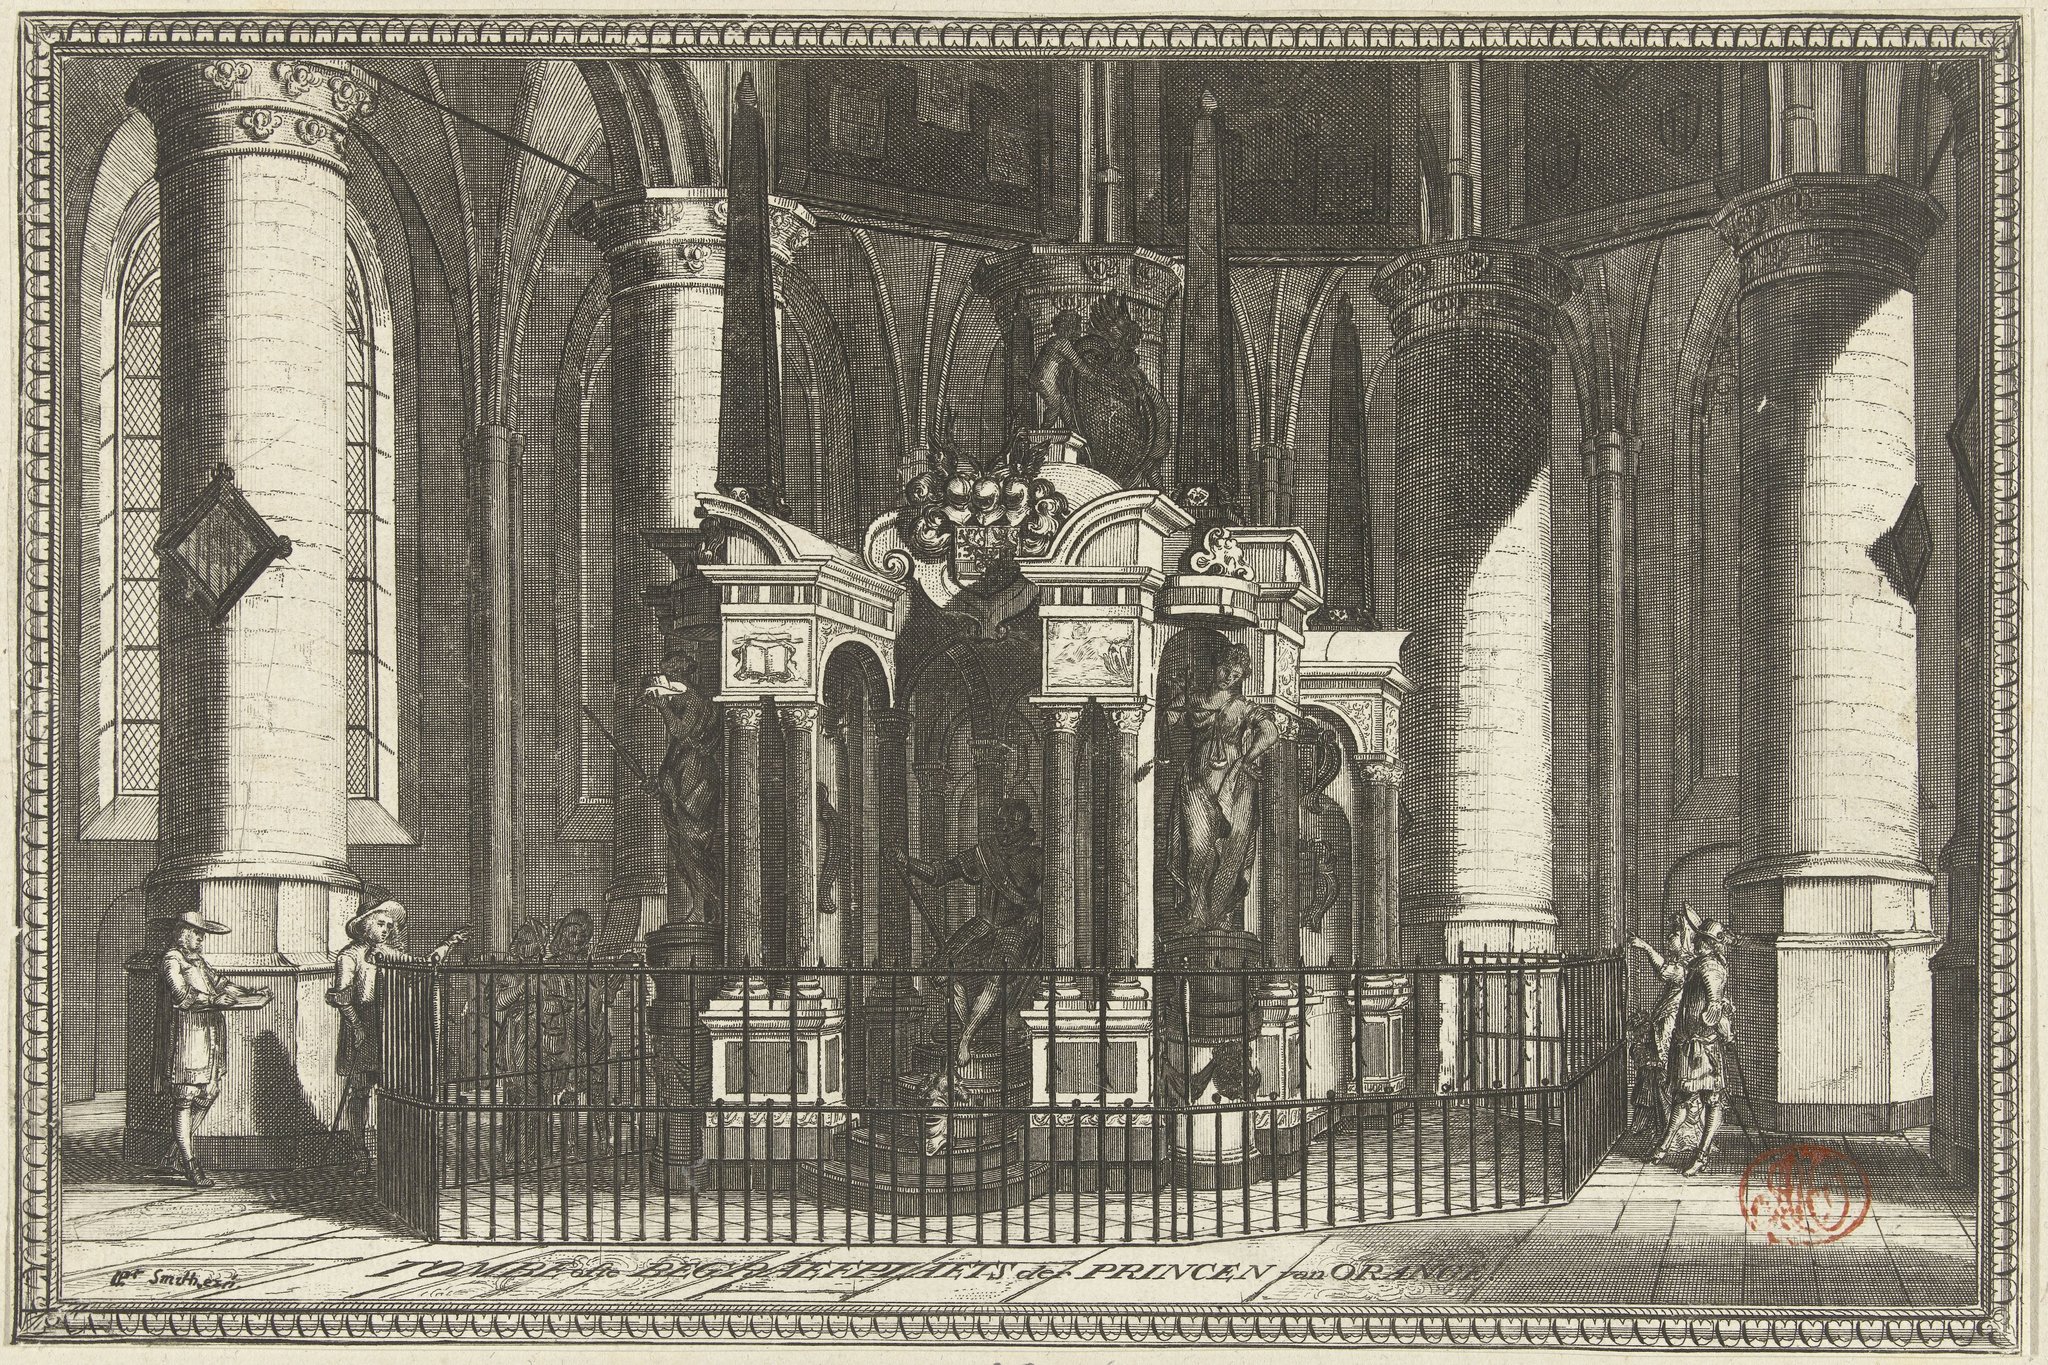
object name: print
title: Tombe ofte begraefplaets der princen van Oranje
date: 1678-1703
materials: paper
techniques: etching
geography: amsterdam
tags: interior of church, grave-building, monumental tomb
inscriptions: collector's mark: Lugt 2228, collector's mark: Lugt 195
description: Deze prent is in 1678 voor het eerst uitgegeven als onderdeel van de rand van de zogenaamde Kaart Figuratief (Caerte figuratyff / Kaerte figuratyf) van Delft, een wandkaart van Delft. Deze kaart bestaat uit een plattegrond van Delft (RP-P-AO-11-8A) met daaromheen een rand. De rand bestaat uit een profiel van Delft (RP-P-AO-11-11), een profiel van Delfshaven met daaronder de wapenschilden van de burgemeesters van de stad (RP-P-AO-13-51-1 en RP-P-AO-13-51-2), 24 kleinere prenten (kaarten, afbeeldingen van gebouwen en graven van bekende personen, o.a. huidige prent, RP-P-AO-11-15, RP-P-AO-11-16, RP-P-AO-11-17, RP-P-AO-11-18, RP-P-AO-11-19, RP-P-AO-11-20, RP-P-AO-11-21, RP-P-AO-11-24, RP-P-AO-11-27, RP-P-AO-11-28, RP-P-AO-11-29, RP-P-AO-11-30, RP-P-AO-11-31, RP-P-AO-11-33C, RP-P-AO-11-34, RP-P-AO-11-35, RP-P-AO-11-35-2, RP-P-AO-13-49, RP-P-AO-13-52, RP-P-AO-13-53, RP-P-AO-13-54-1 en RP-P-1909-6463) en een beschrijving van de stad (RP-P-AO-11-8E). De eerste druk van deze Kaart Figuratief (1678) werd, in opdracht van het Delftse stadsbestuur, verzorgd door Pieter Smith. In 1680 leverde Smith ook vijfhonderd afdrukken van de randprenten die bestemd waren voor Dirk Evertsz. Bleyswijcks 'Beschryvinge der stadt Delft' (1667) en het tweede deel: 'Vervolg van de beschryvinge der stadt Delft' (1680). In het tweede deel zat een bijlage waarin beschreven staat welke prenten waar in het eerste en tweede deel ingebonden dienden te worden. Een deel van de prenten was dus bestemd voor het in 1667 verschenen eerste deel en kon met het verschijnen van het tweede deel in 1680 alsnog worden ingebonden. Hierdoor wordt vaak gedacht dat de prenten uit het eerste deel dateren uit 1667, hetgeen niet klopt. De huidige prent is zodoende ook gebruikt in: Bleyswijck, Dirk Evertsz. Beschryvinge der stadt Delft, betreffende des selfs situatie, oorsprong en ouderdom, opkomst en voortgangh (…). Delft: Arnold Bon, 1667 (prenten vanaf 1680 ingebonden), p. 261. Pieter Mortier (I) verzorgde in 1703, tevens in opdracht van het stadsbestuur, een tweede uitgave van de Kaart Figuratief. Voor deze druk bracht graveur Thomas van der Wilt enkele aanpassingen aan op de platen van de plattegrond. De randplaten lijken, op de plaat met de wapens van de burgemeesters na, ongewijzigd te zijn gebleven. De plattegrond is in 1752, waarschijnlijk zonder de randprenten, opnieuw uitgegeven. Een deel van de randprenten, waaronder de huidige prent, is in 1729 opnieuw gebruikt in: Beschryving der stadt Delft, behelzende een zeer naaukeurige en uitvoerige verhandeling van deszelfs eerste oorsprong (…). Delft: Reinier Boitet, 1729. Op twee na (die van de Nieuwe en Oude Kerk) paste Boitet de platen aan, waardoor van deze prenten een tweede staat ontstond. Of de huidige prent is gebruikt als onderdeel van de rand van de Kaart Figuratief uit 1678 of 1703, of is gebruikt in 'Beschryvinge der stadt Delft' (1667, prenten 1680), is niet na te gaan.